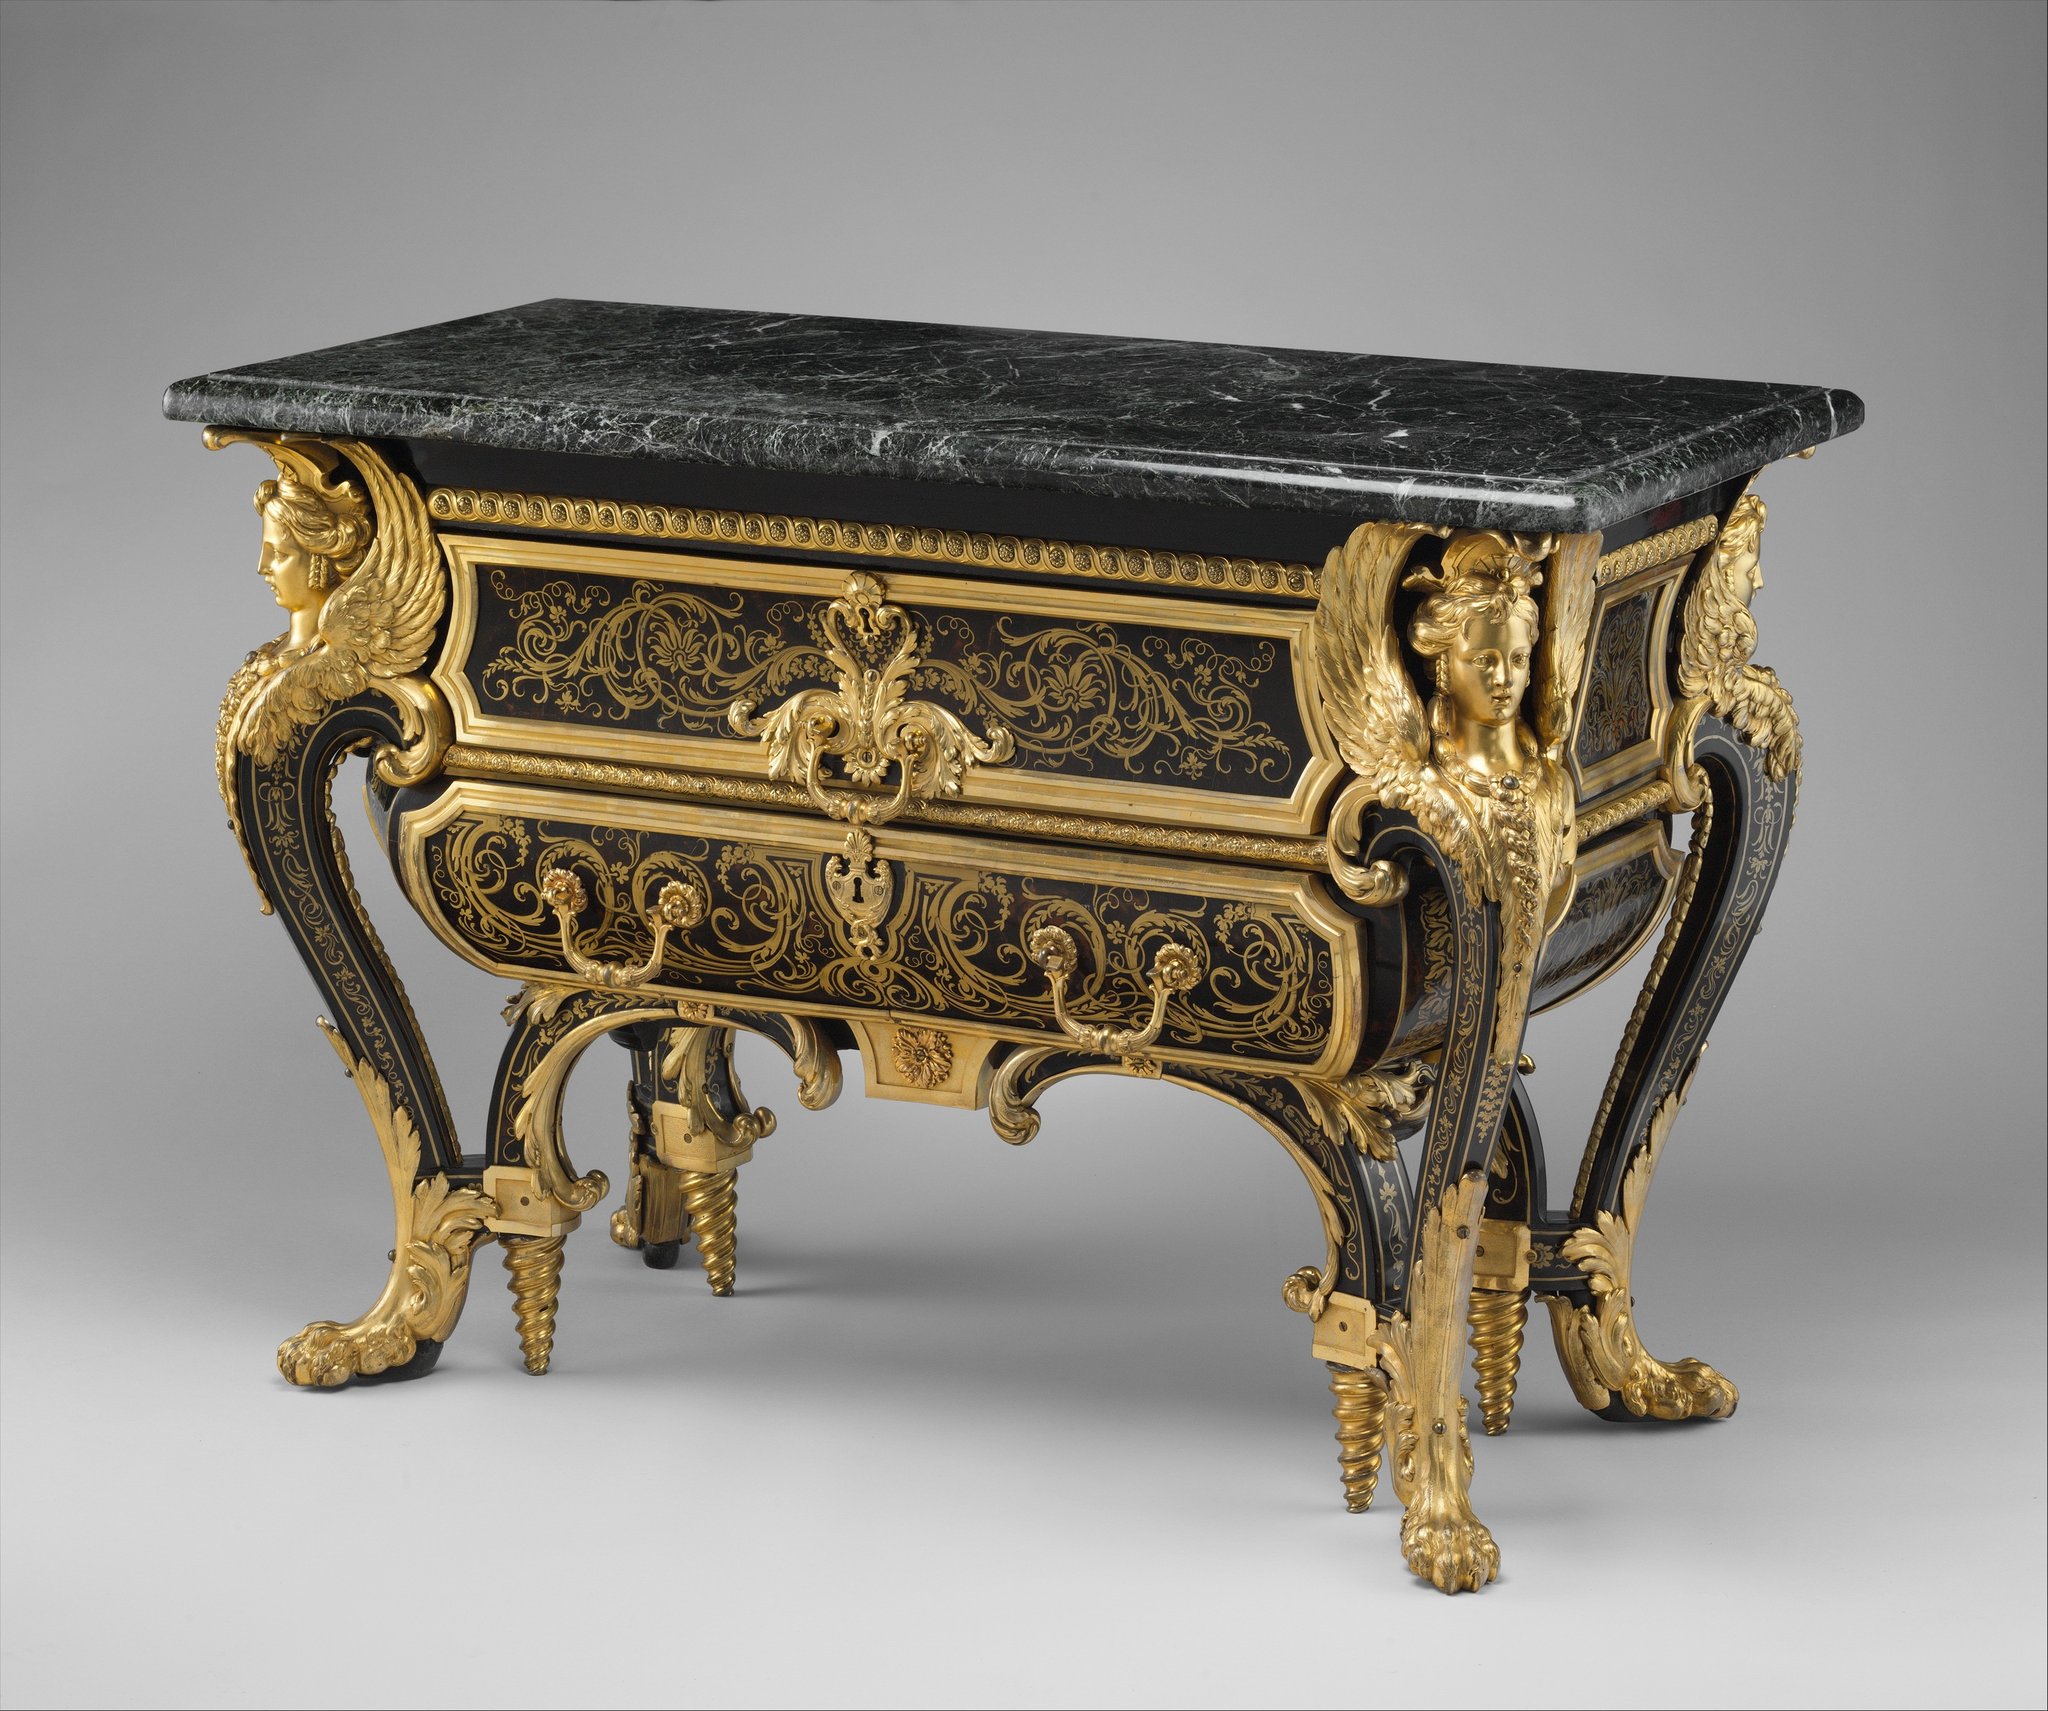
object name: commode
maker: andré charles boulle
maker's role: maker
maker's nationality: french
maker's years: 1642-1732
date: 1710-1720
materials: brass, wood, gilt bronze, marble, shell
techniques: engraving, veneering